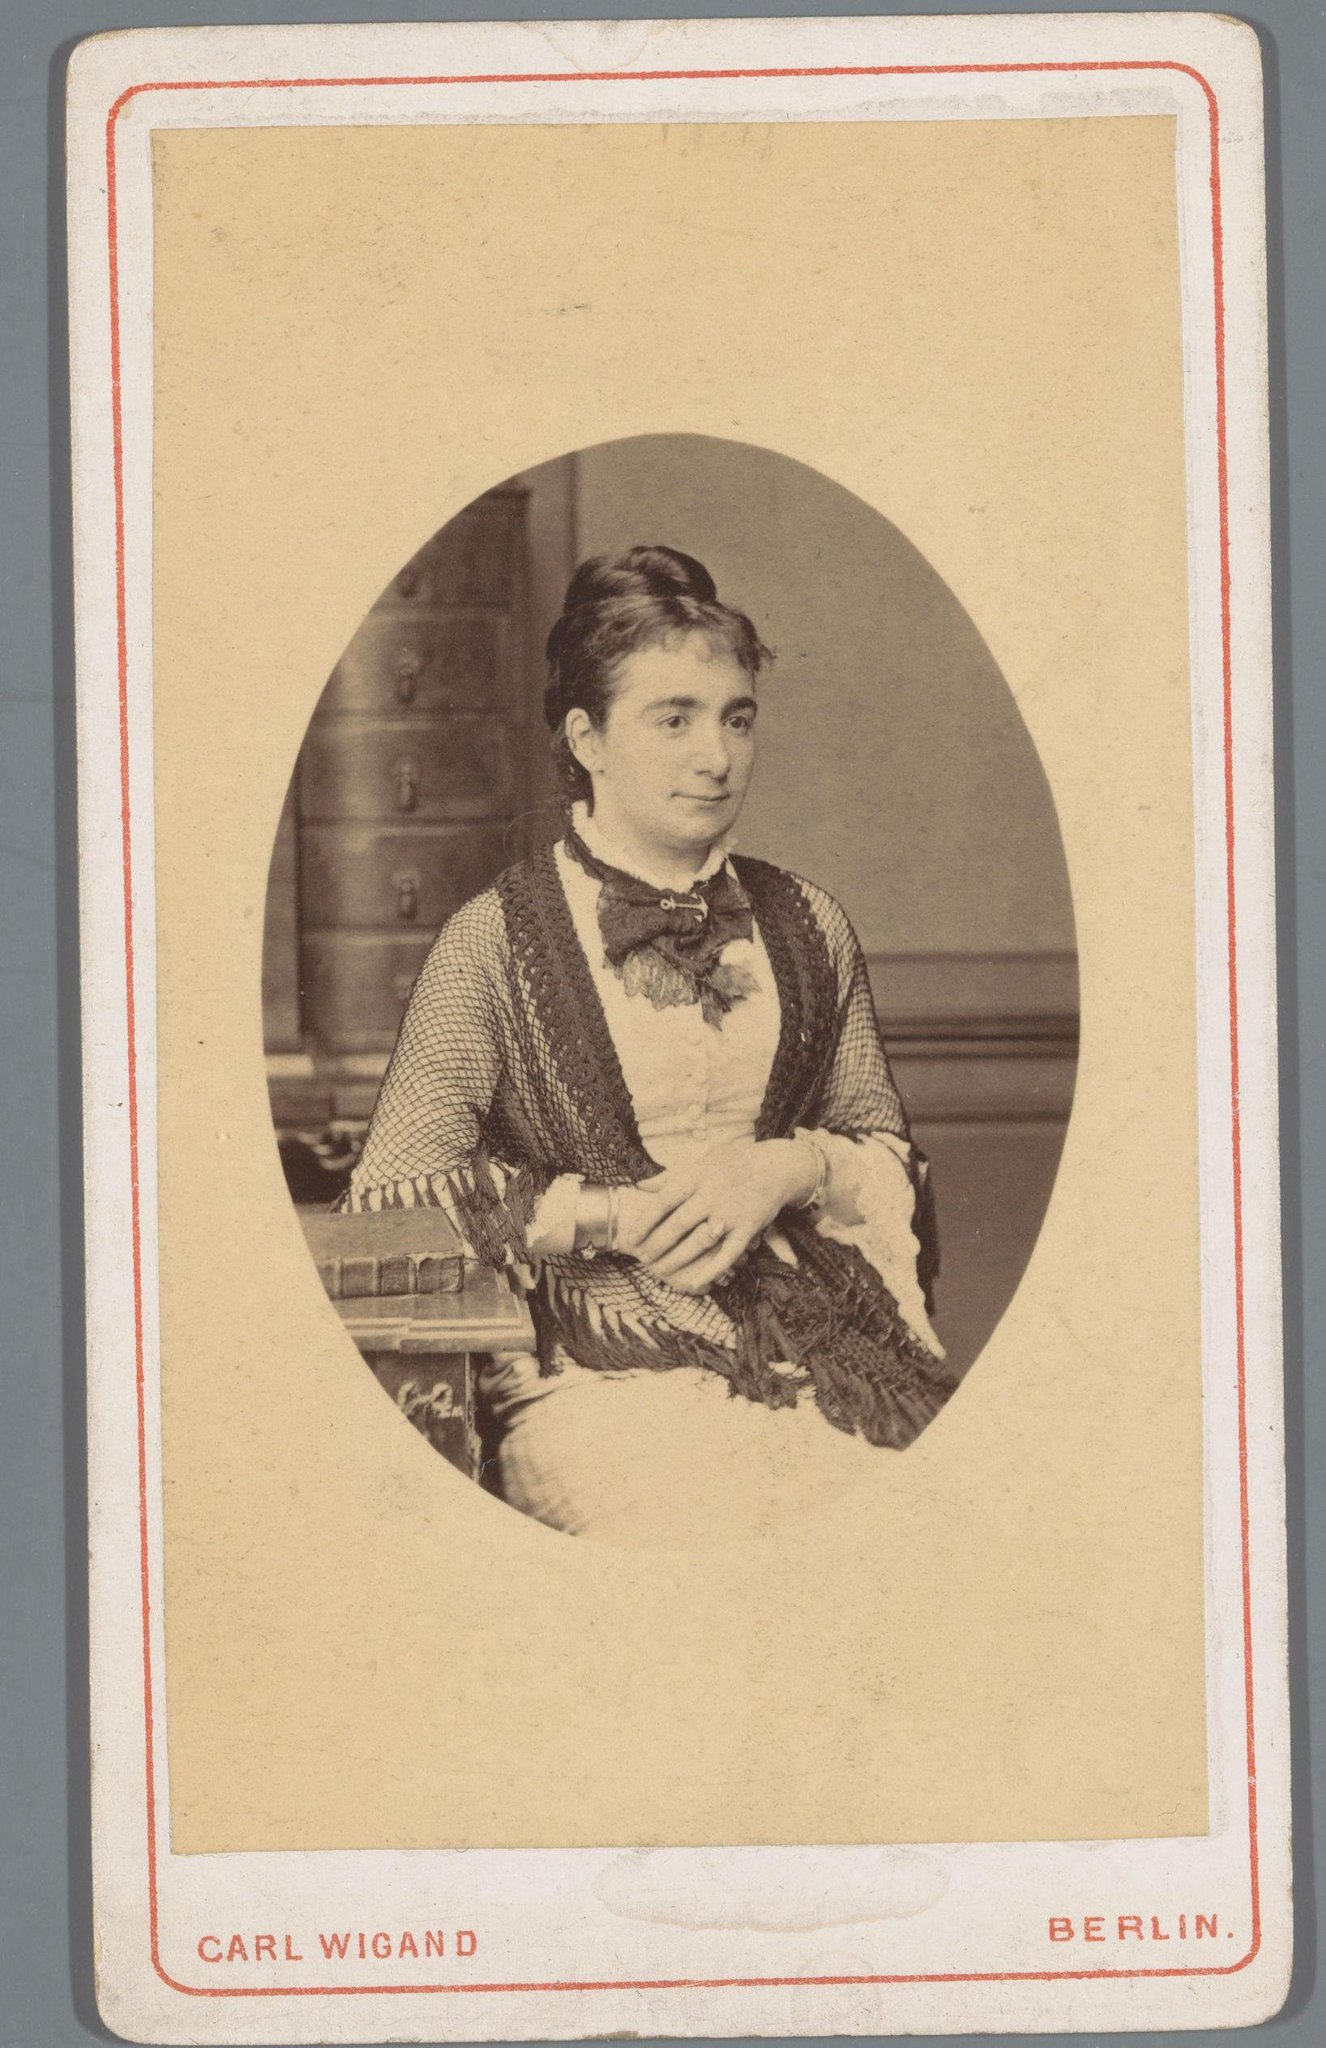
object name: photograph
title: Portret van een onbekende vrouw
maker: carl wigand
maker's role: painter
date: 1876-1886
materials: cardboard, paper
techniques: albumen print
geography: berlin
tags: adult woman, anonymous historical person portrayed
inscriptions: address: ‘66, UNTER DEN LINDEN/ BERLIN.’, inscription: ‘Vor Nachbildung gesetzlich geschützt./ MEDAILLE BERLIN, 1865./ SILBERNE MEDAILLE PARIS, 1867.’